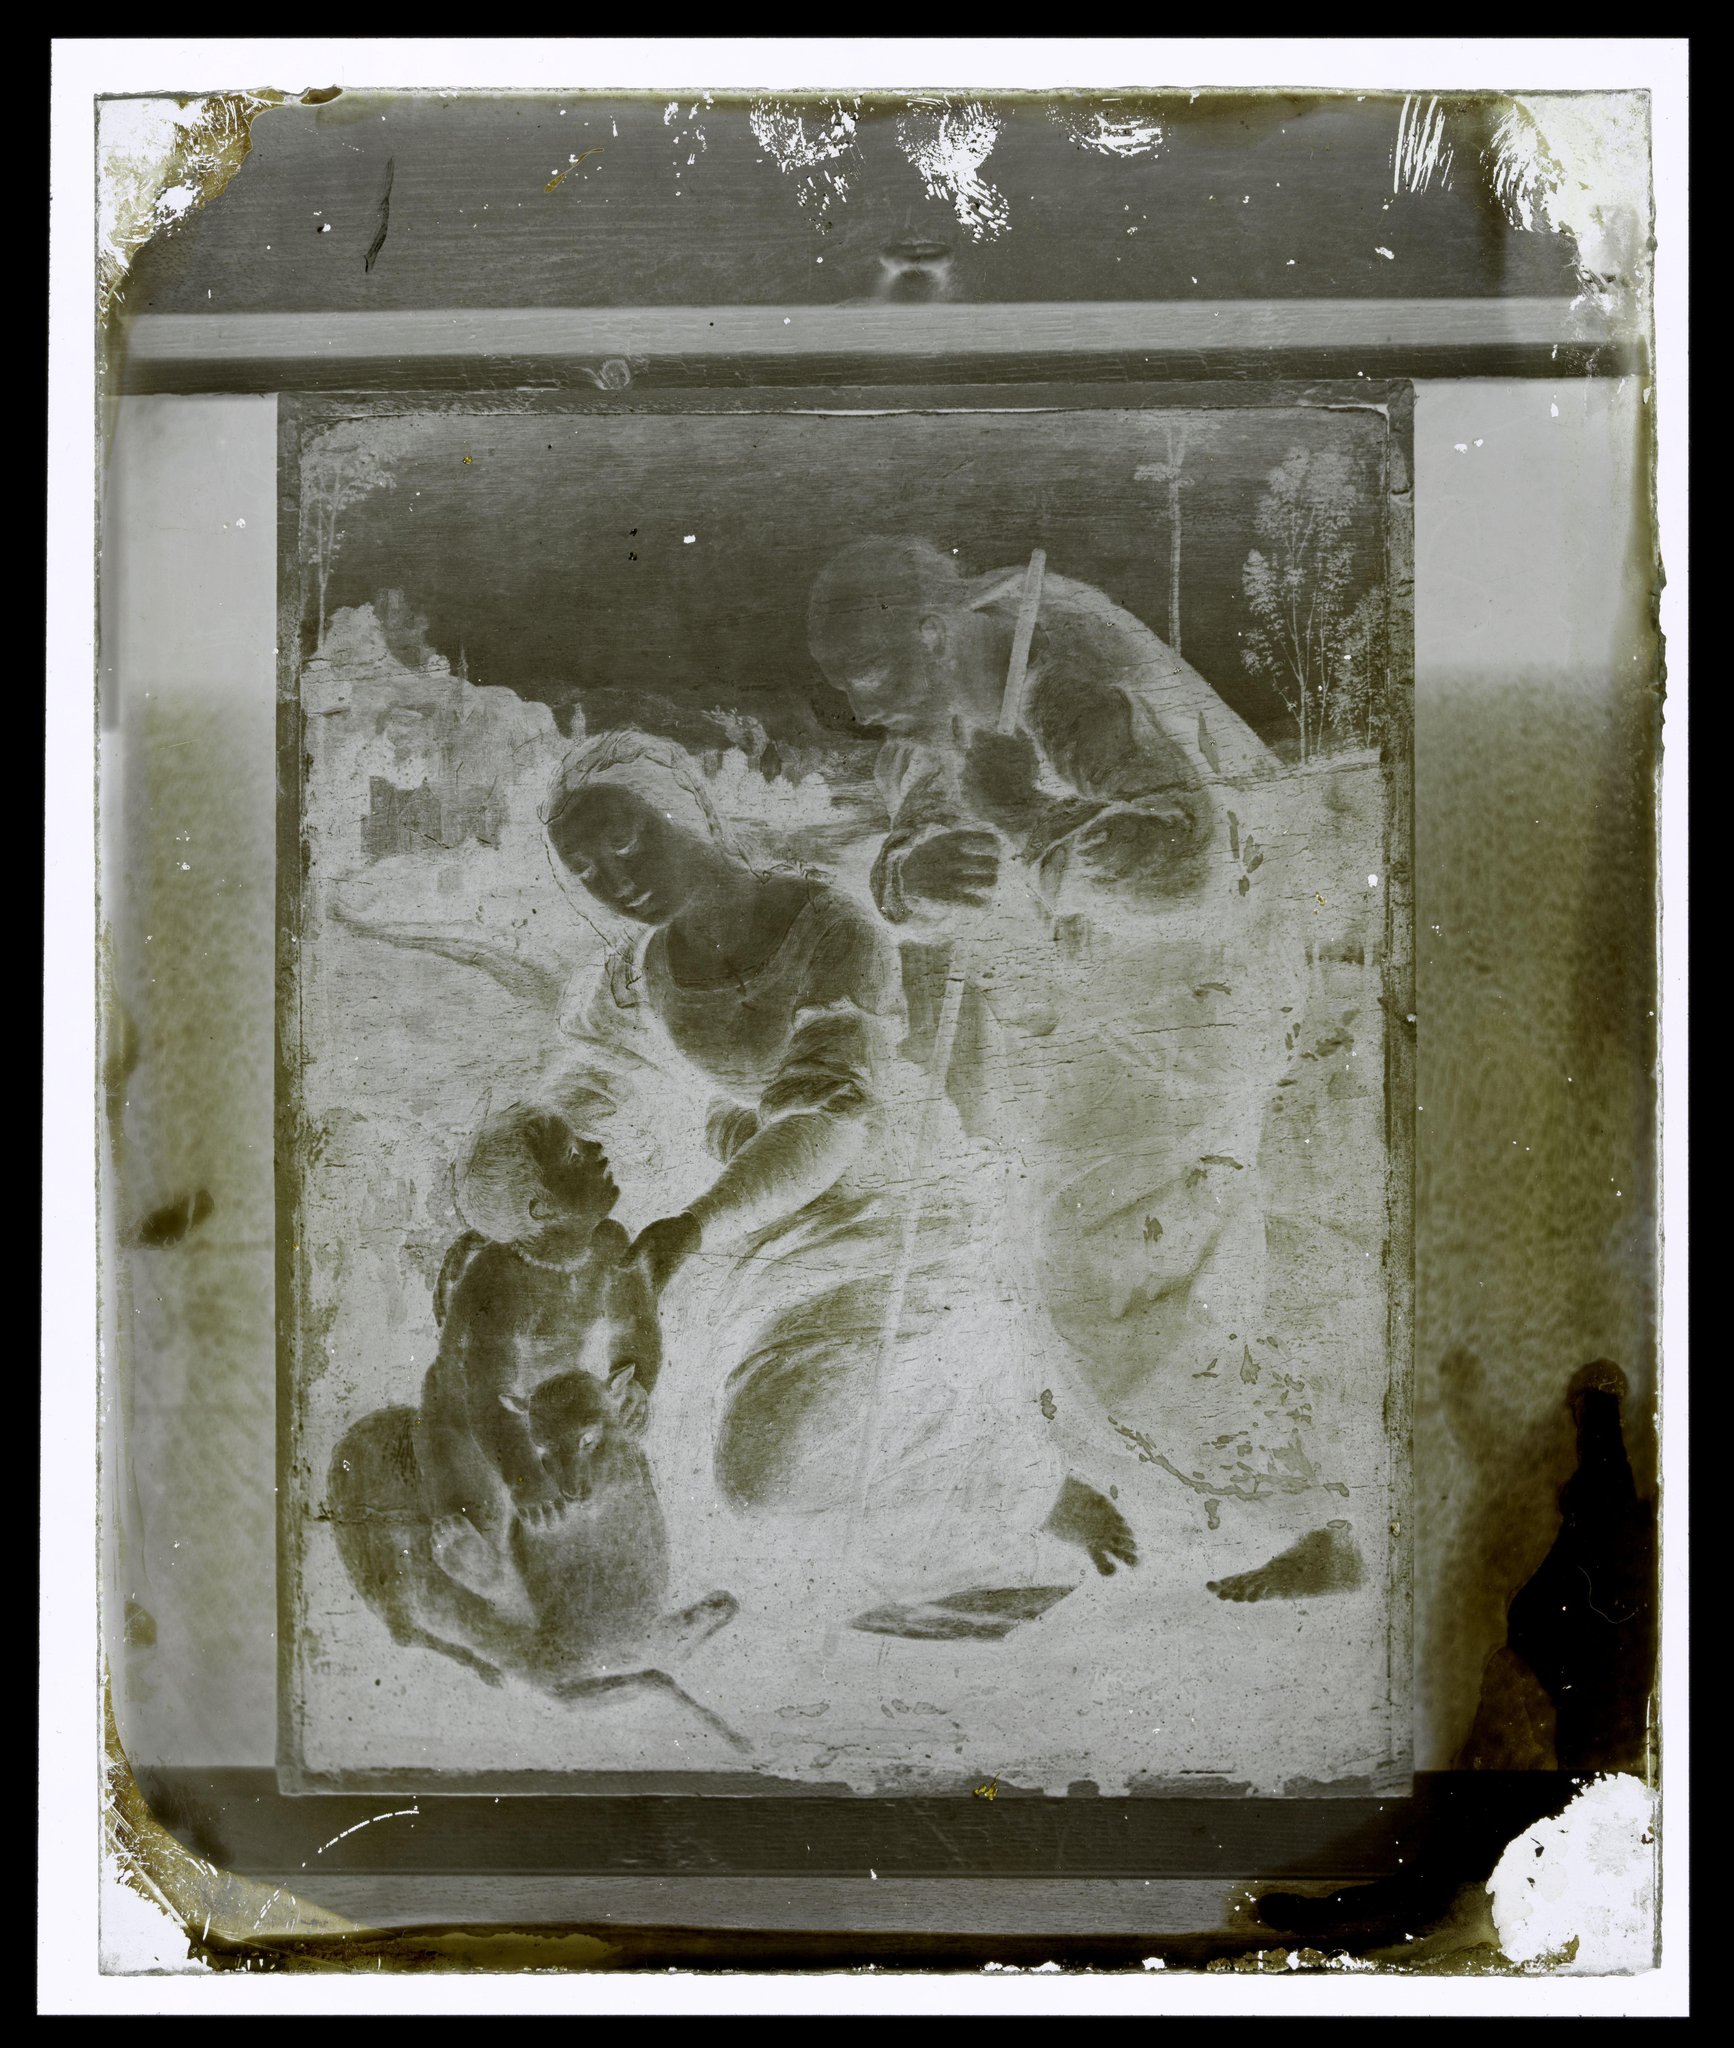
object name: reproduction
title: Fotoreproductie van een schilderij van de Heilige familie met een lam, door Rafaël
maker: laurens lodewijk kleijn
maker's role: draughtsman, painter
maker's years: 1826-1909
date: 1865-1900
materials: glass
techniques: collodion process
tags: holy family (alone), 'trinitas terrestris'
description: Onderdeel van een groep glasnegatieven uit de nalatenschap van de schilder Laurens Lodewijk Kleijn, met stillevens, portretten, zelfportretten en kunstreproducties.